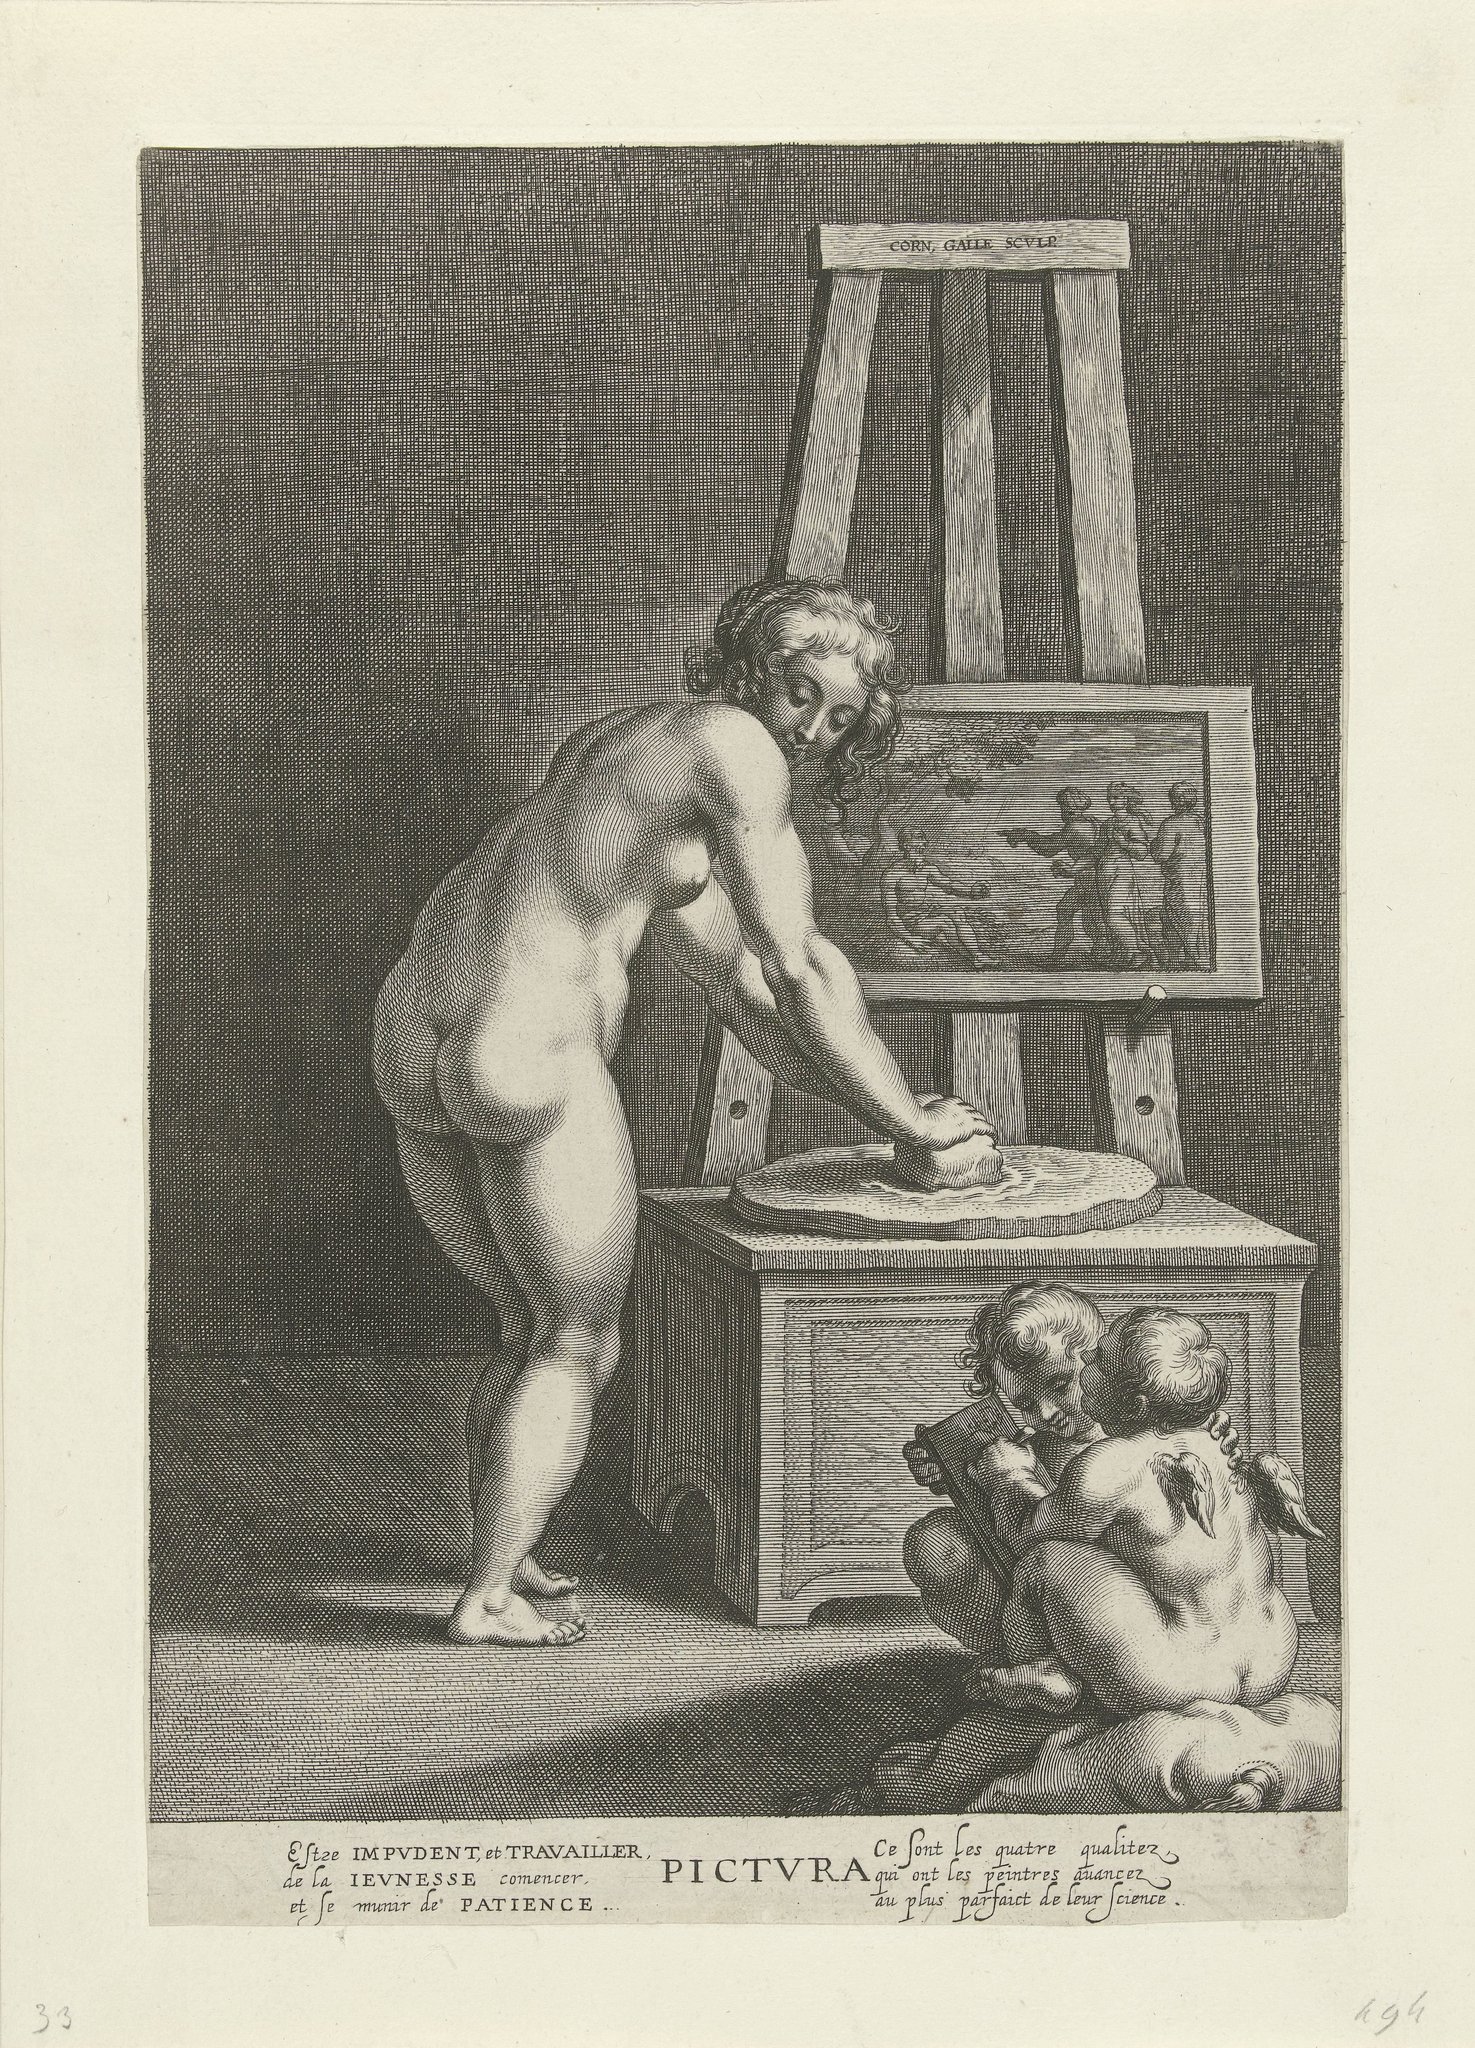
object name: print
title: Pictura (de Schilderkunst)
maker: cornelis galle (i)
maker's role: print maker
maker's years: 1576-1650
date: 1610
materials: paper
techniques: engraving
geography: southern netherlands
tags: 'pictura', symbolic representations, allegories and emblems ~ painting; 'pittura' (ripa)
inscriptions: collector's mark: Lugt 240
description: Pictura de personificatie van de schilderkunst vermaalt pigmenten in haar atelier. Op een ezel staat een schilderij. Op de grond zitten twee putti die een tekening van haar maken. Onder de voorstelling een Frans vers.